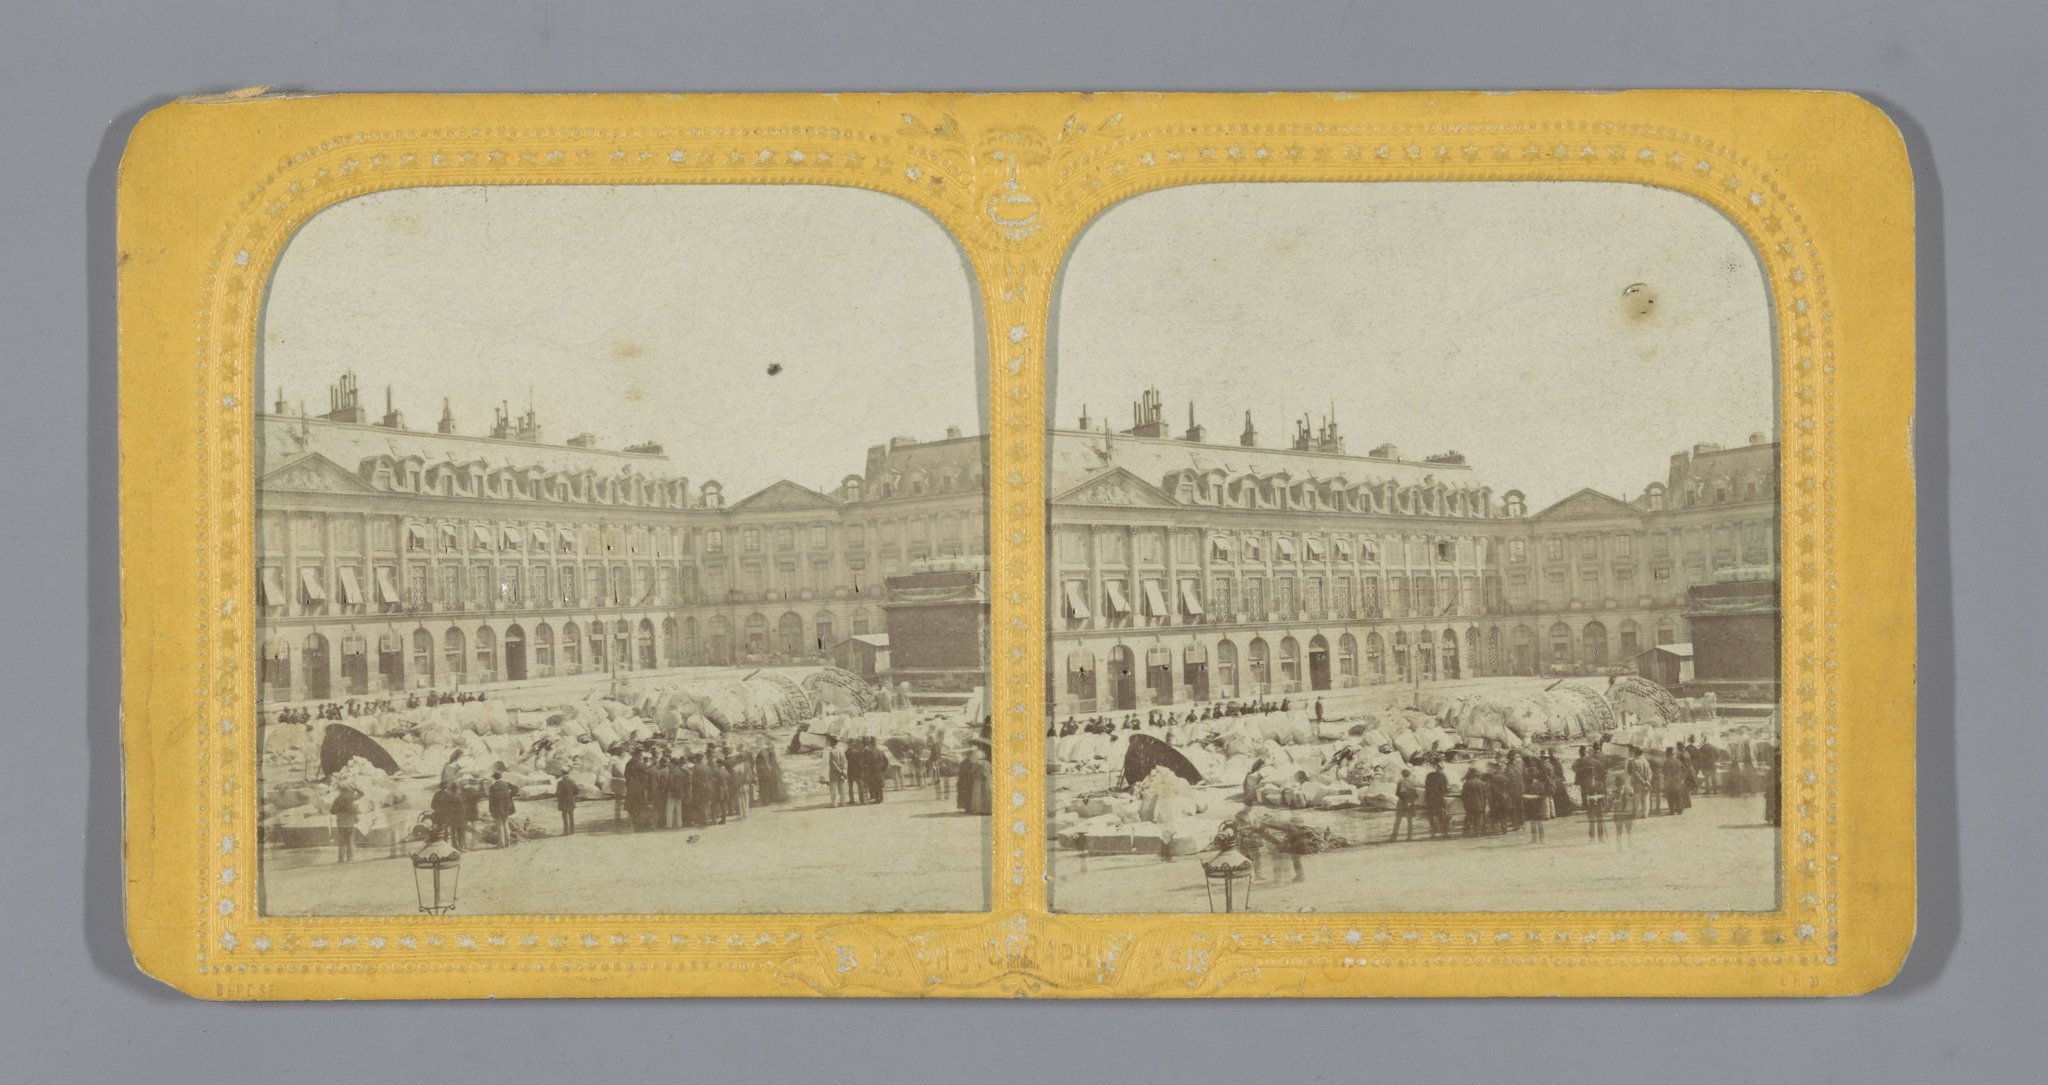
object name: tissue stereograph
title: Place Vendôme met de restanten van de Colonne Vendôme tijdens de Commune van Parijs in 1871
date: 1871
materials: cardboard, paper, photographic support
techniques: albumen print, cutting, hand coloring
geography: paris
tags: square, place, circus, etc., ruin of a building ~ architecture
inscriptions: inscription: ‘Déposé’, check stamp: ‘B.K. PHOTOGRAPHIE PARIS’